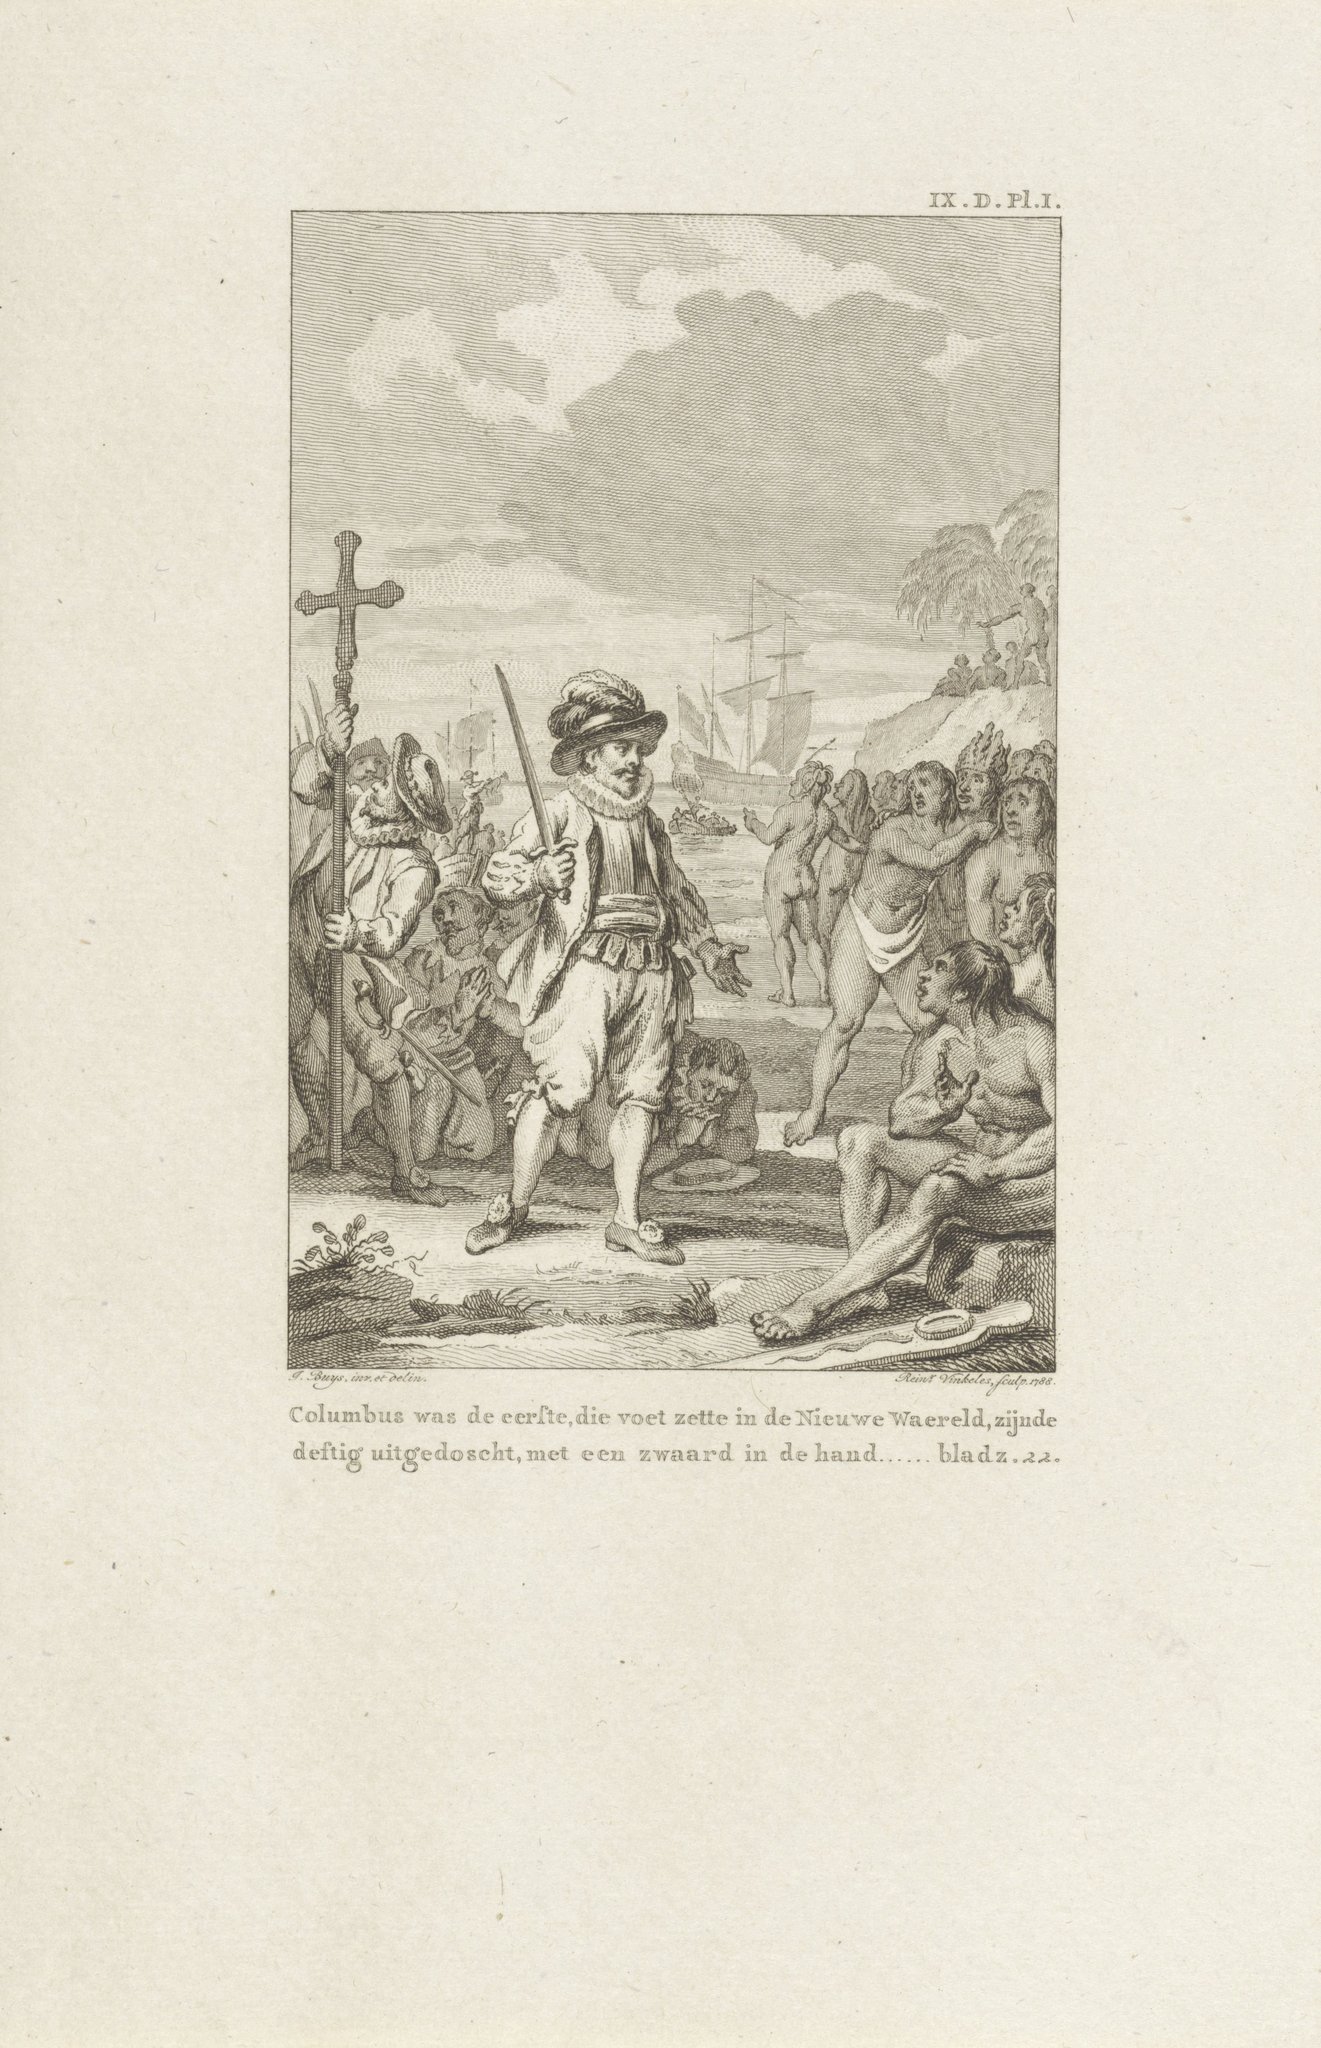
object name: book illustration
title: Columbus was de eerste (...)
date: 1788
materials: paper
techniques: engraving, etching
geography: amsterdam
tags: indigenous peoples of central america, historical events and situations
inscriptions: collector's mark: Lugt 240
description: Christoffel Columbus komt met zijn vloot aan in Amerika. Een paar van zijn mannen richten een kruis op. Mogelijk is hier de aankomst op San Salvador (Guanahani) afgebeeld. Rechts de lokale bevolking, waarschijnlijk de Lucayan. Rechtsboven: IX.D.Pl.I. Rechtsonder: Bladz.22.